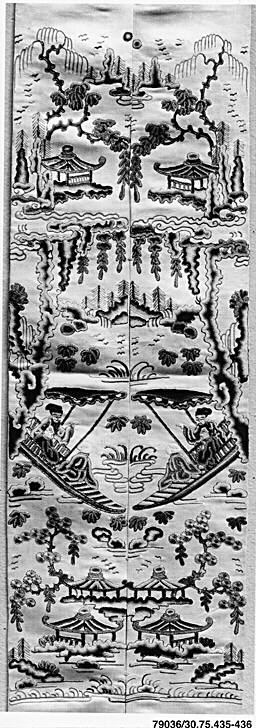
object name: sleeve band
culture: chinese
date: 1801-1900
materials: metal thread, silk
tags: boats